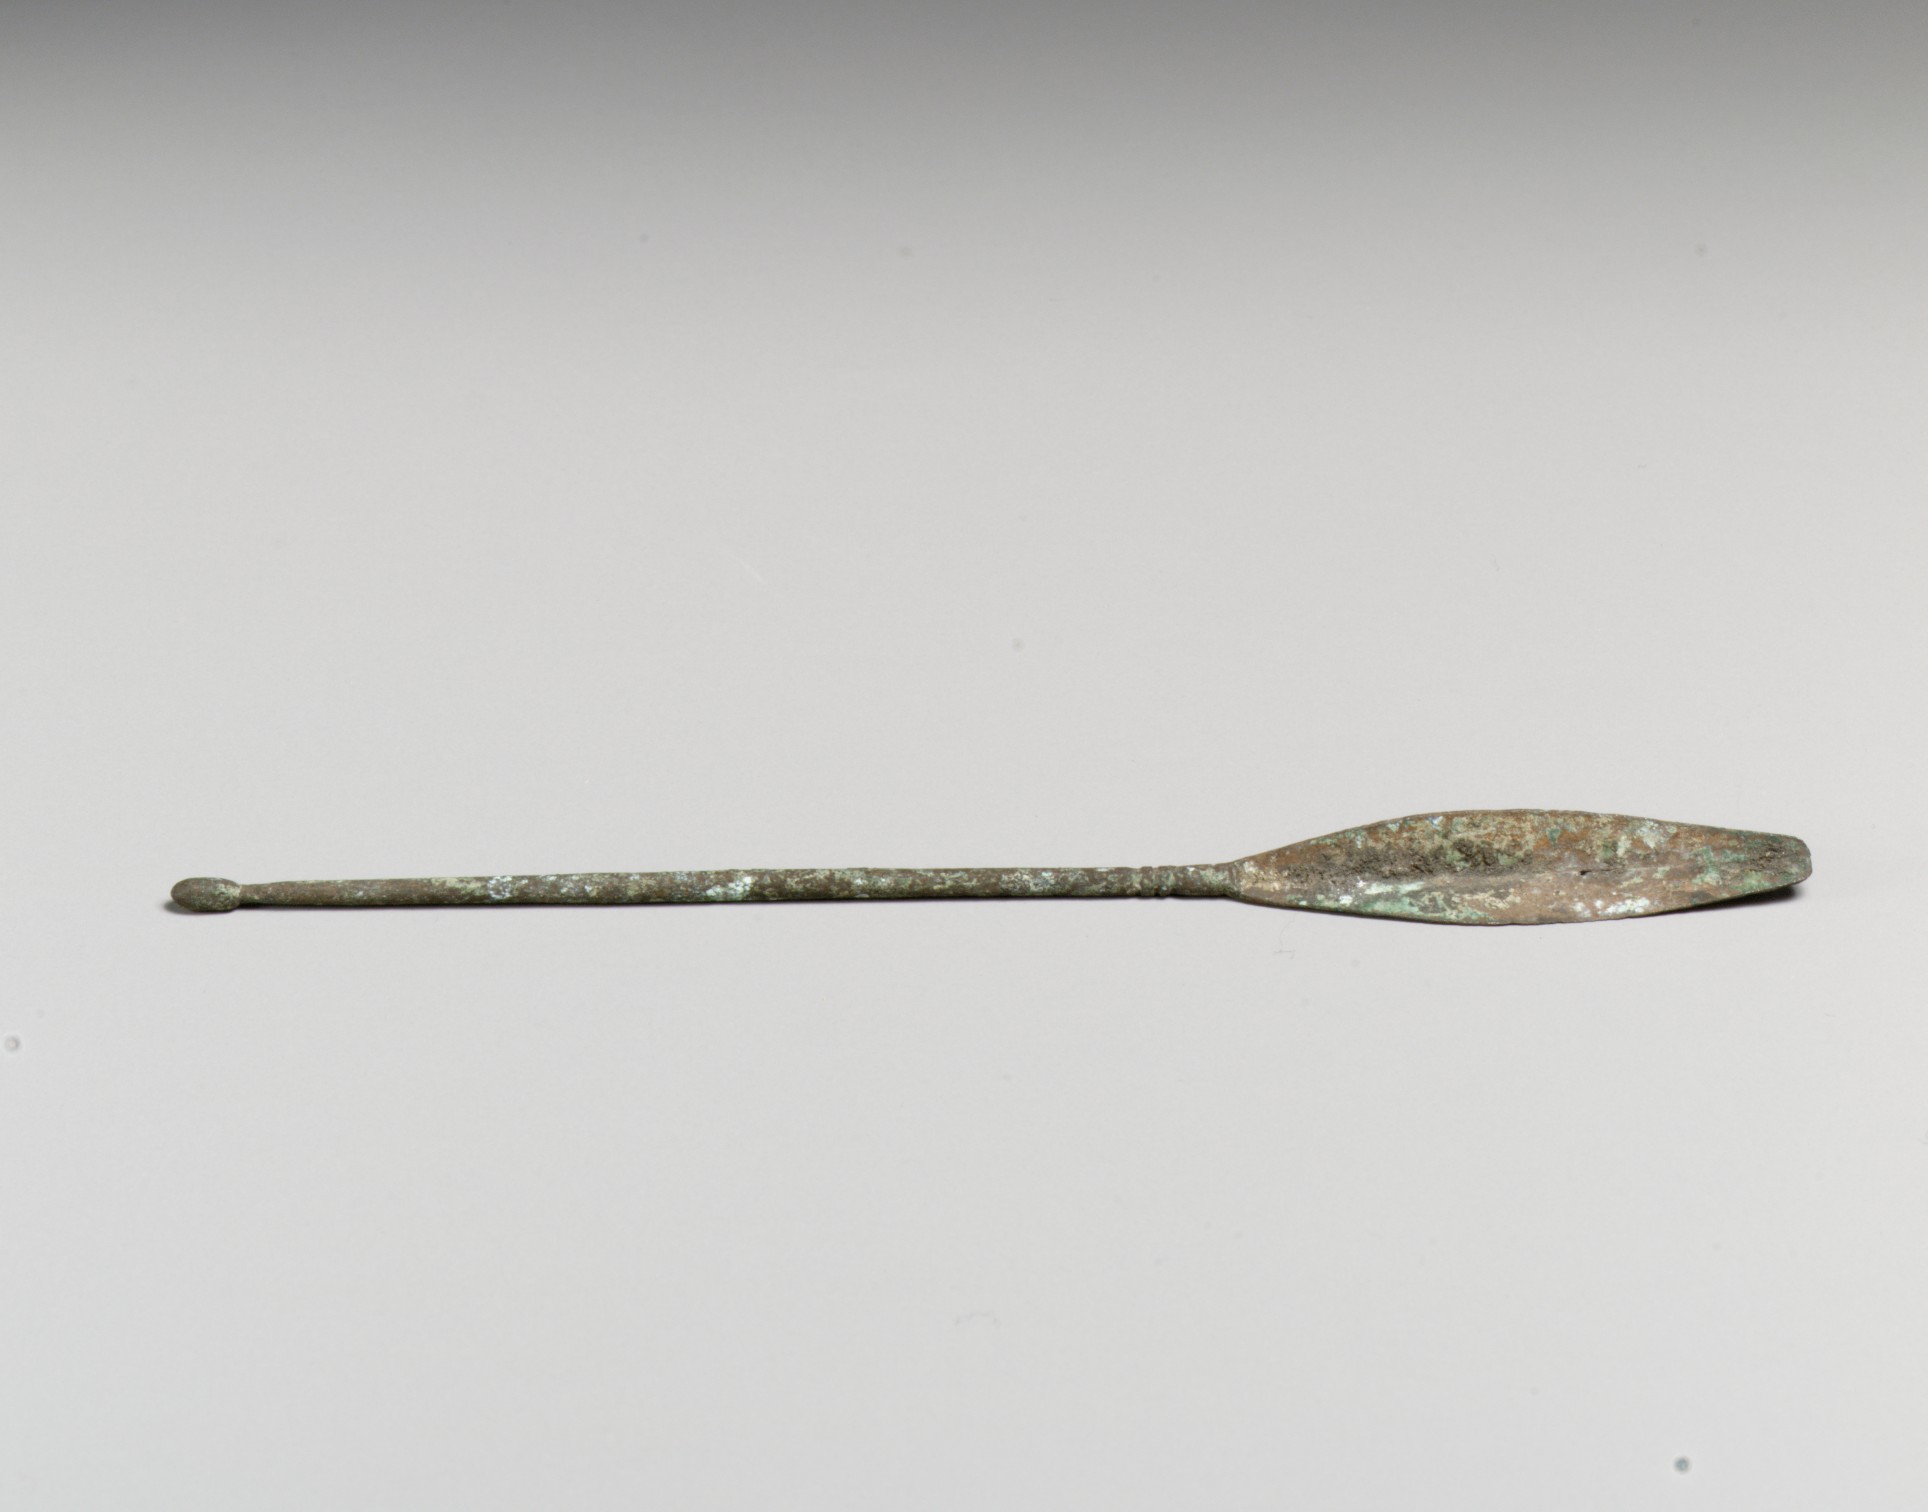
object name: curette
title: Curettes ?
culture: roman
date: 670 BCE-330 CE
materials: bronze